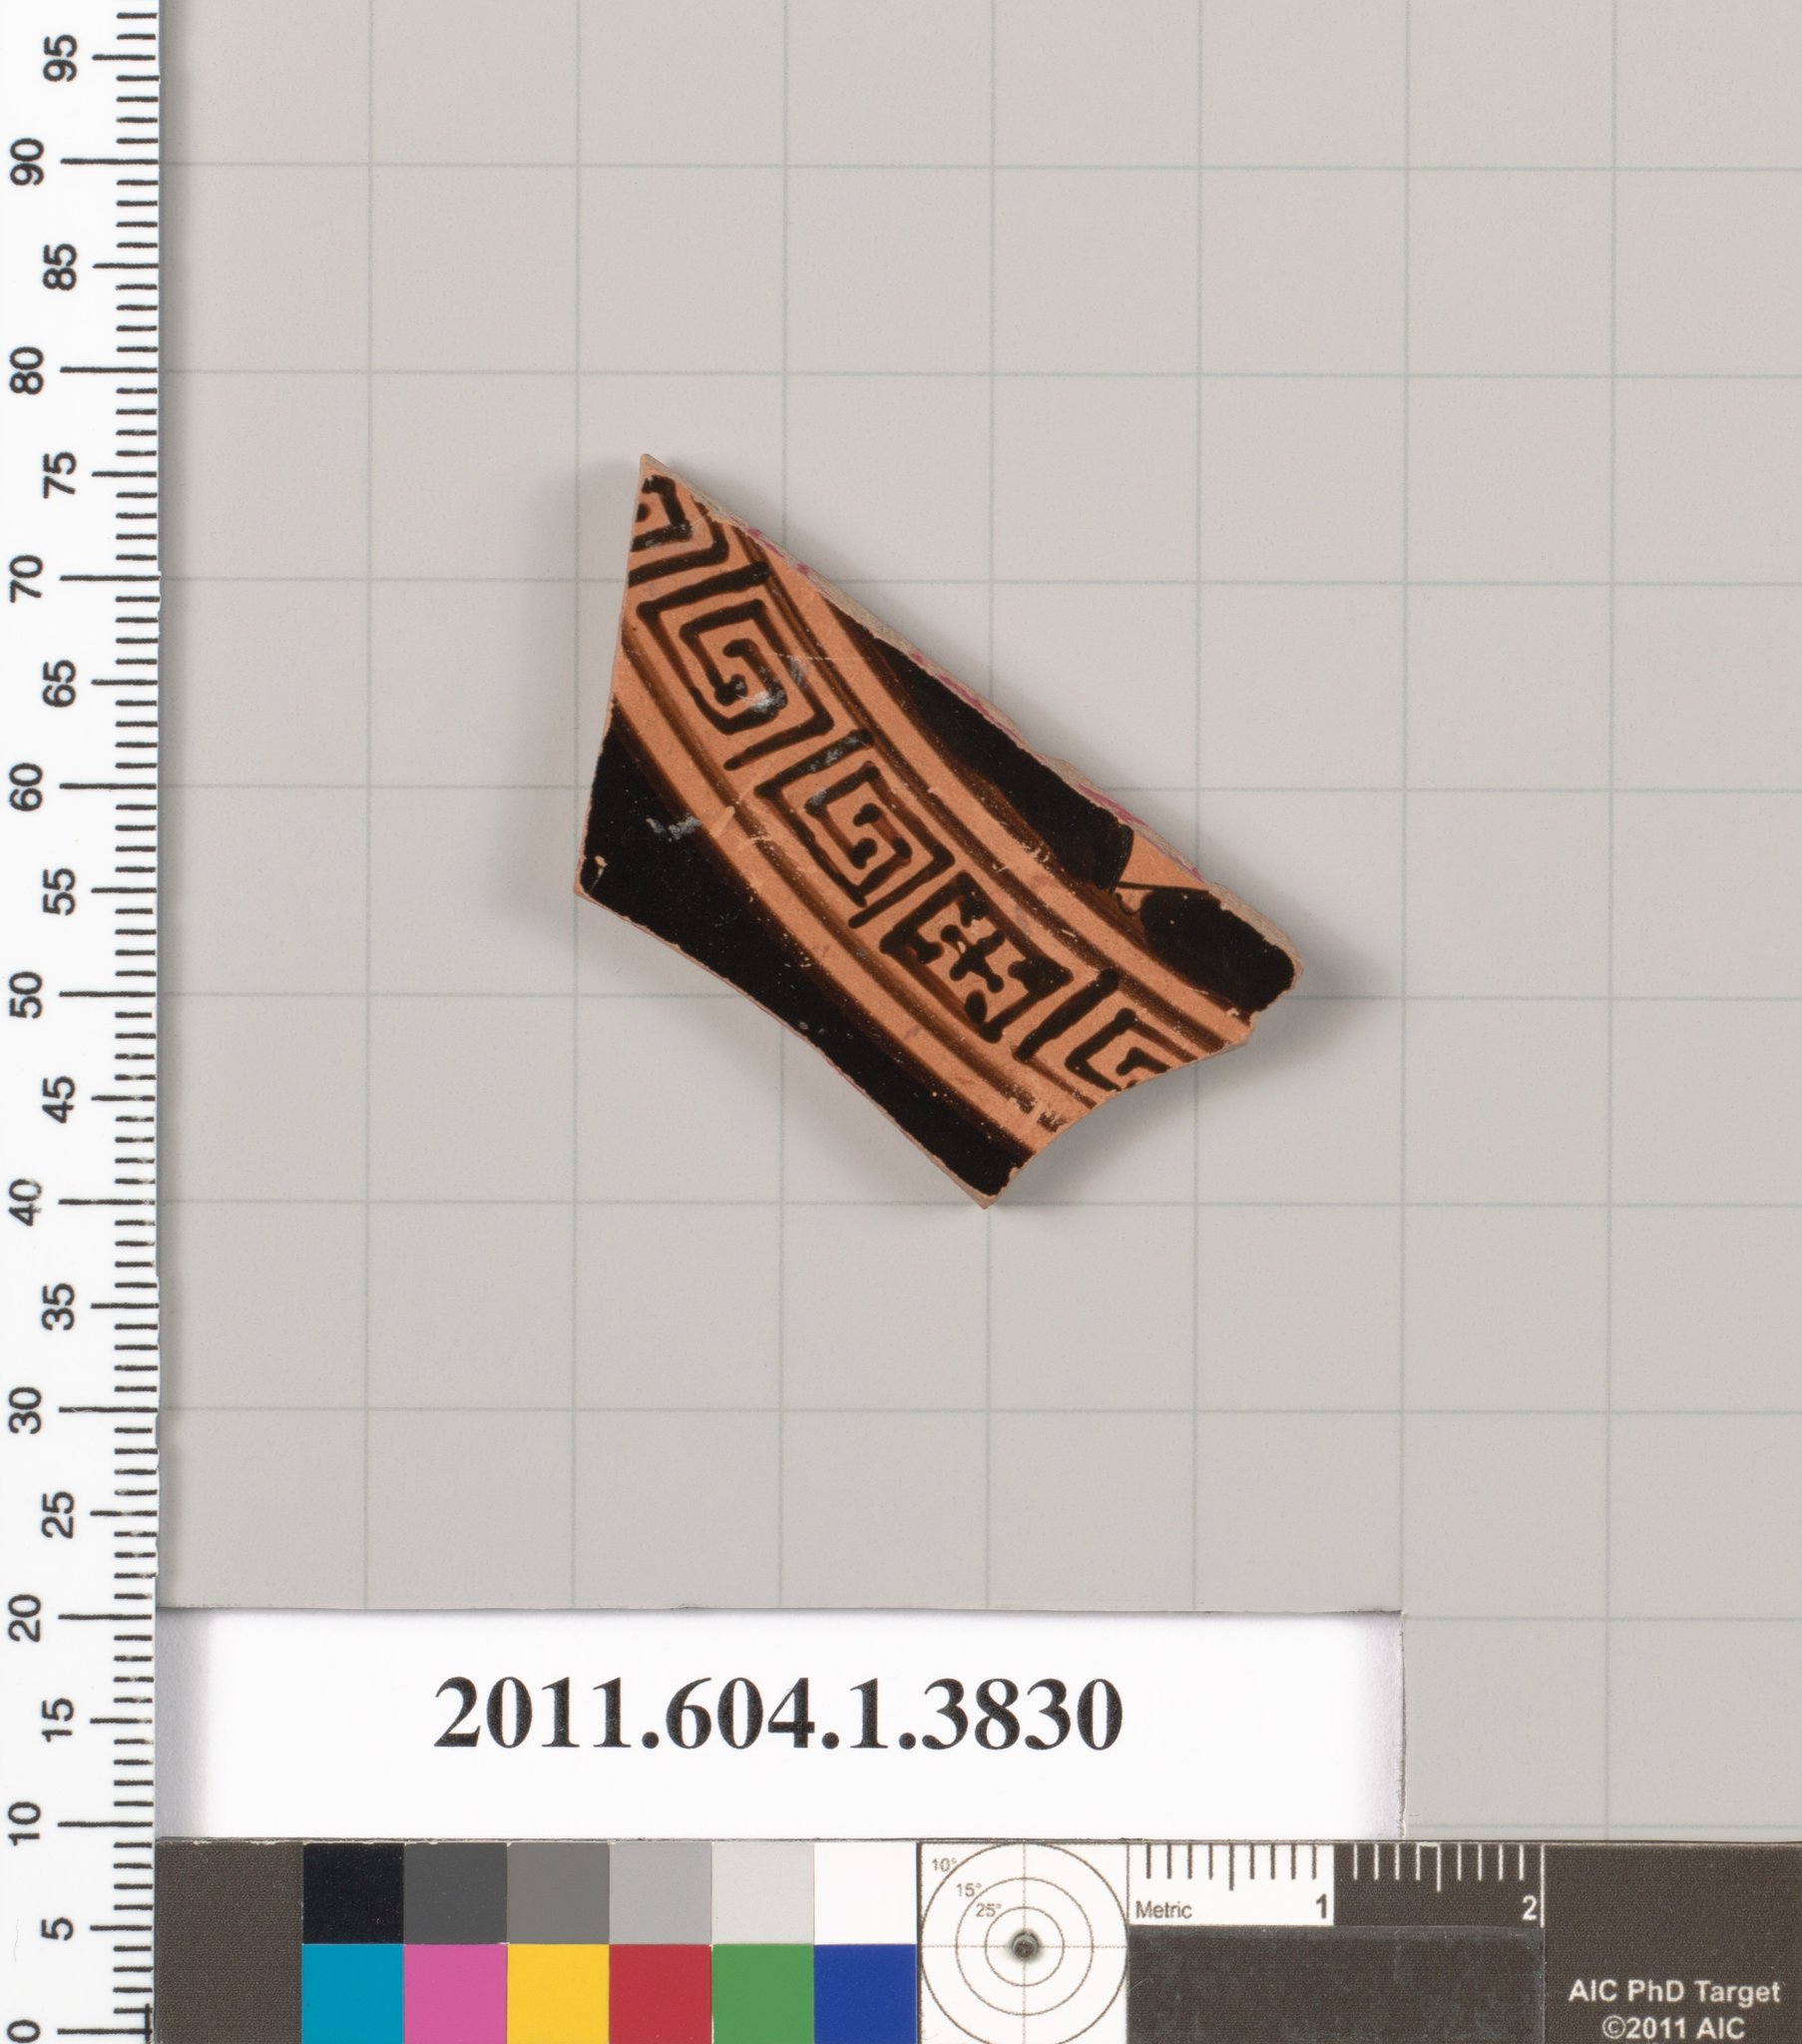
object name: kylix fragment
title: Terracotta fragment of a kylix (drinking cup)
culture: greek, attic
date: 490-470 BCE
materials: terracotta